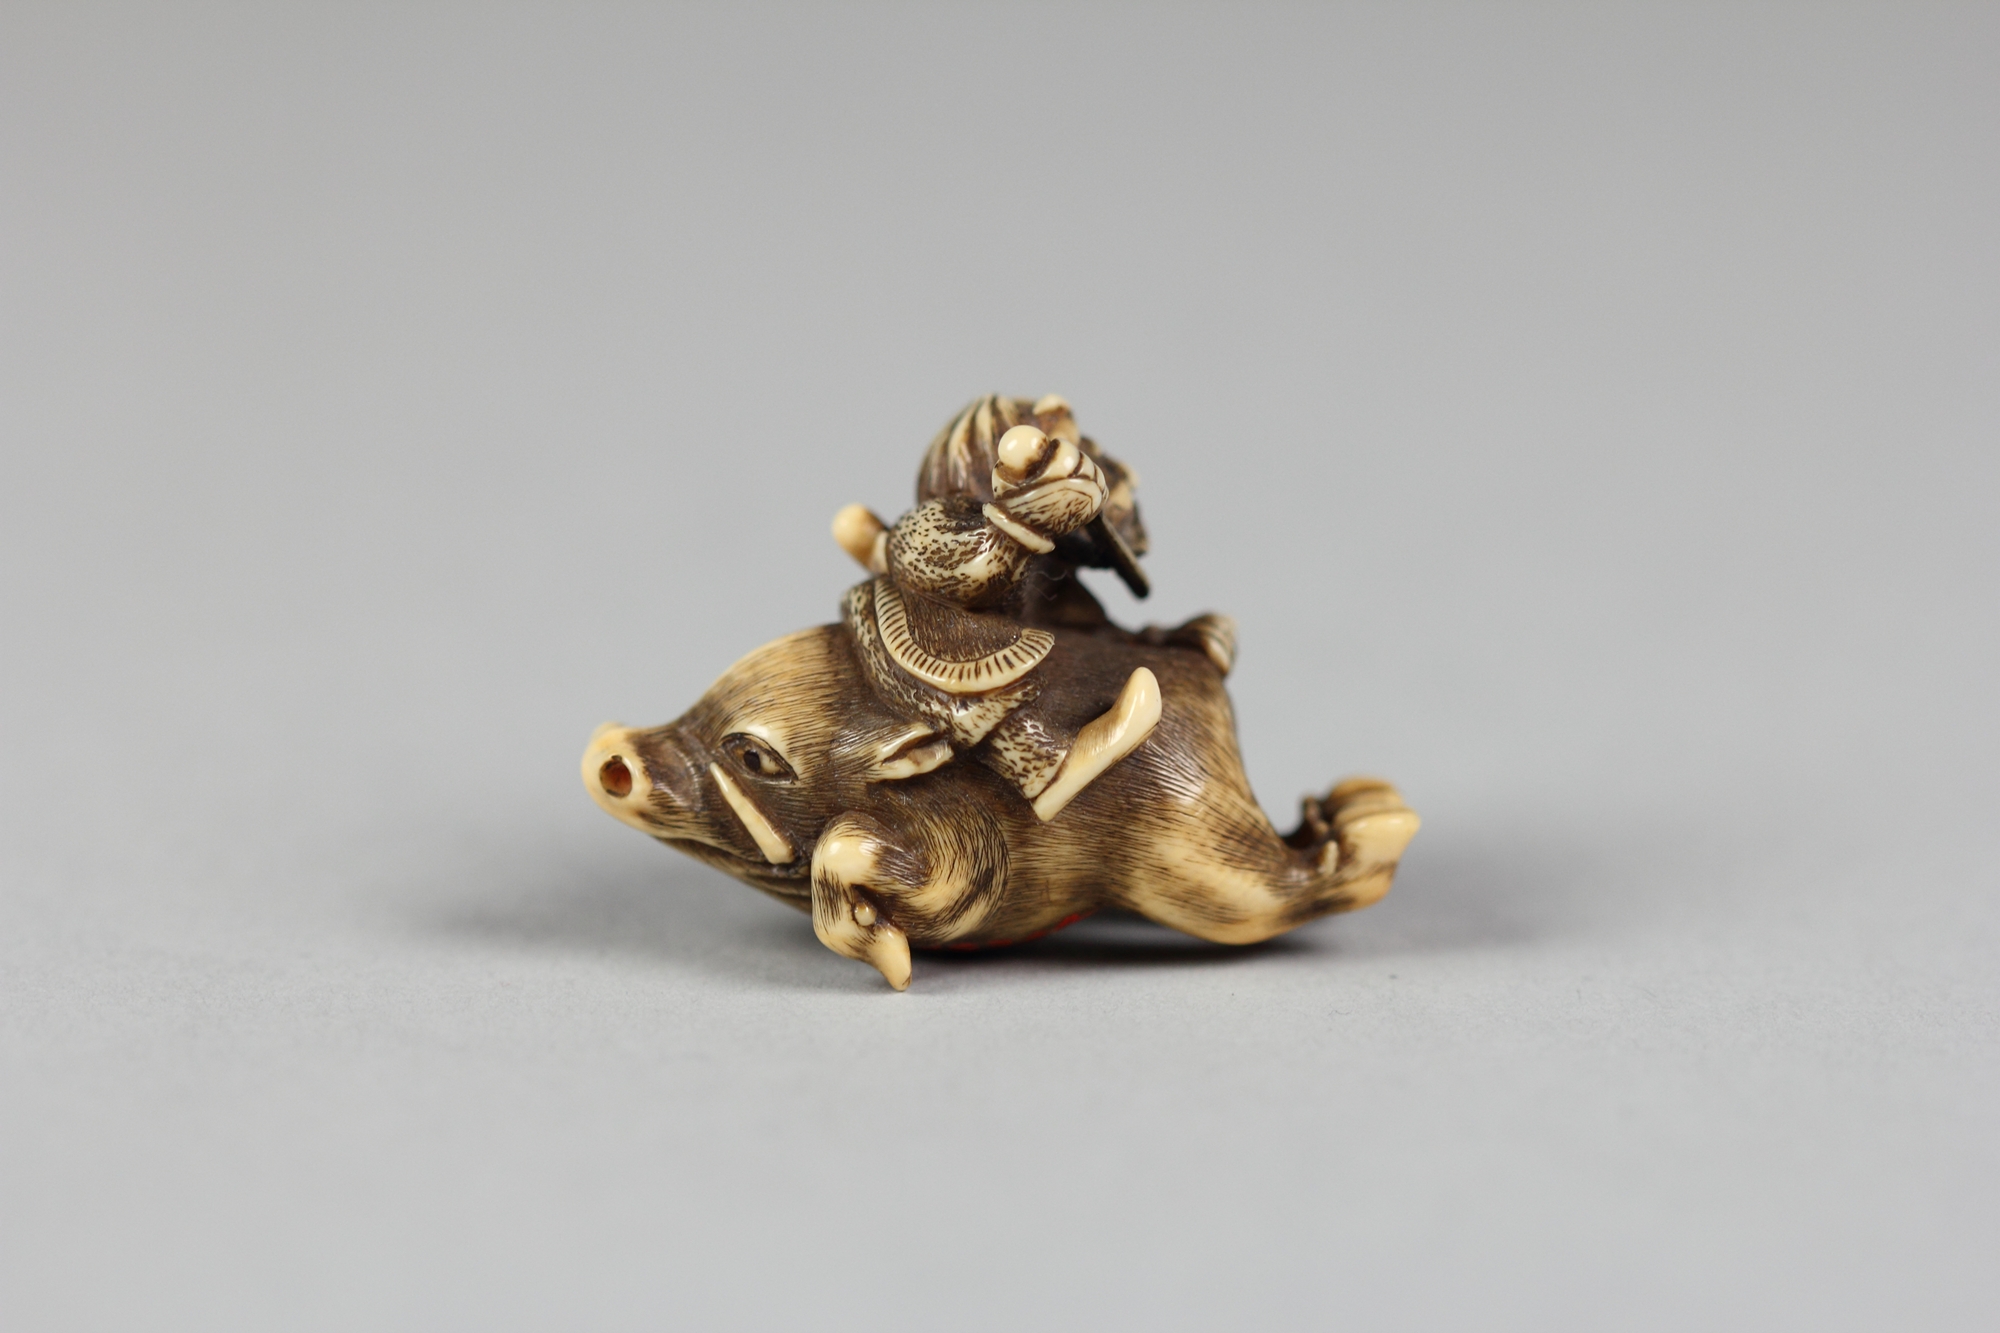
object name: netsuke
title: Netsuke of Tadatsune Slaying the Wild Boar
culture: japanese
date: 1801-1900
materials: ivory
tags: boars